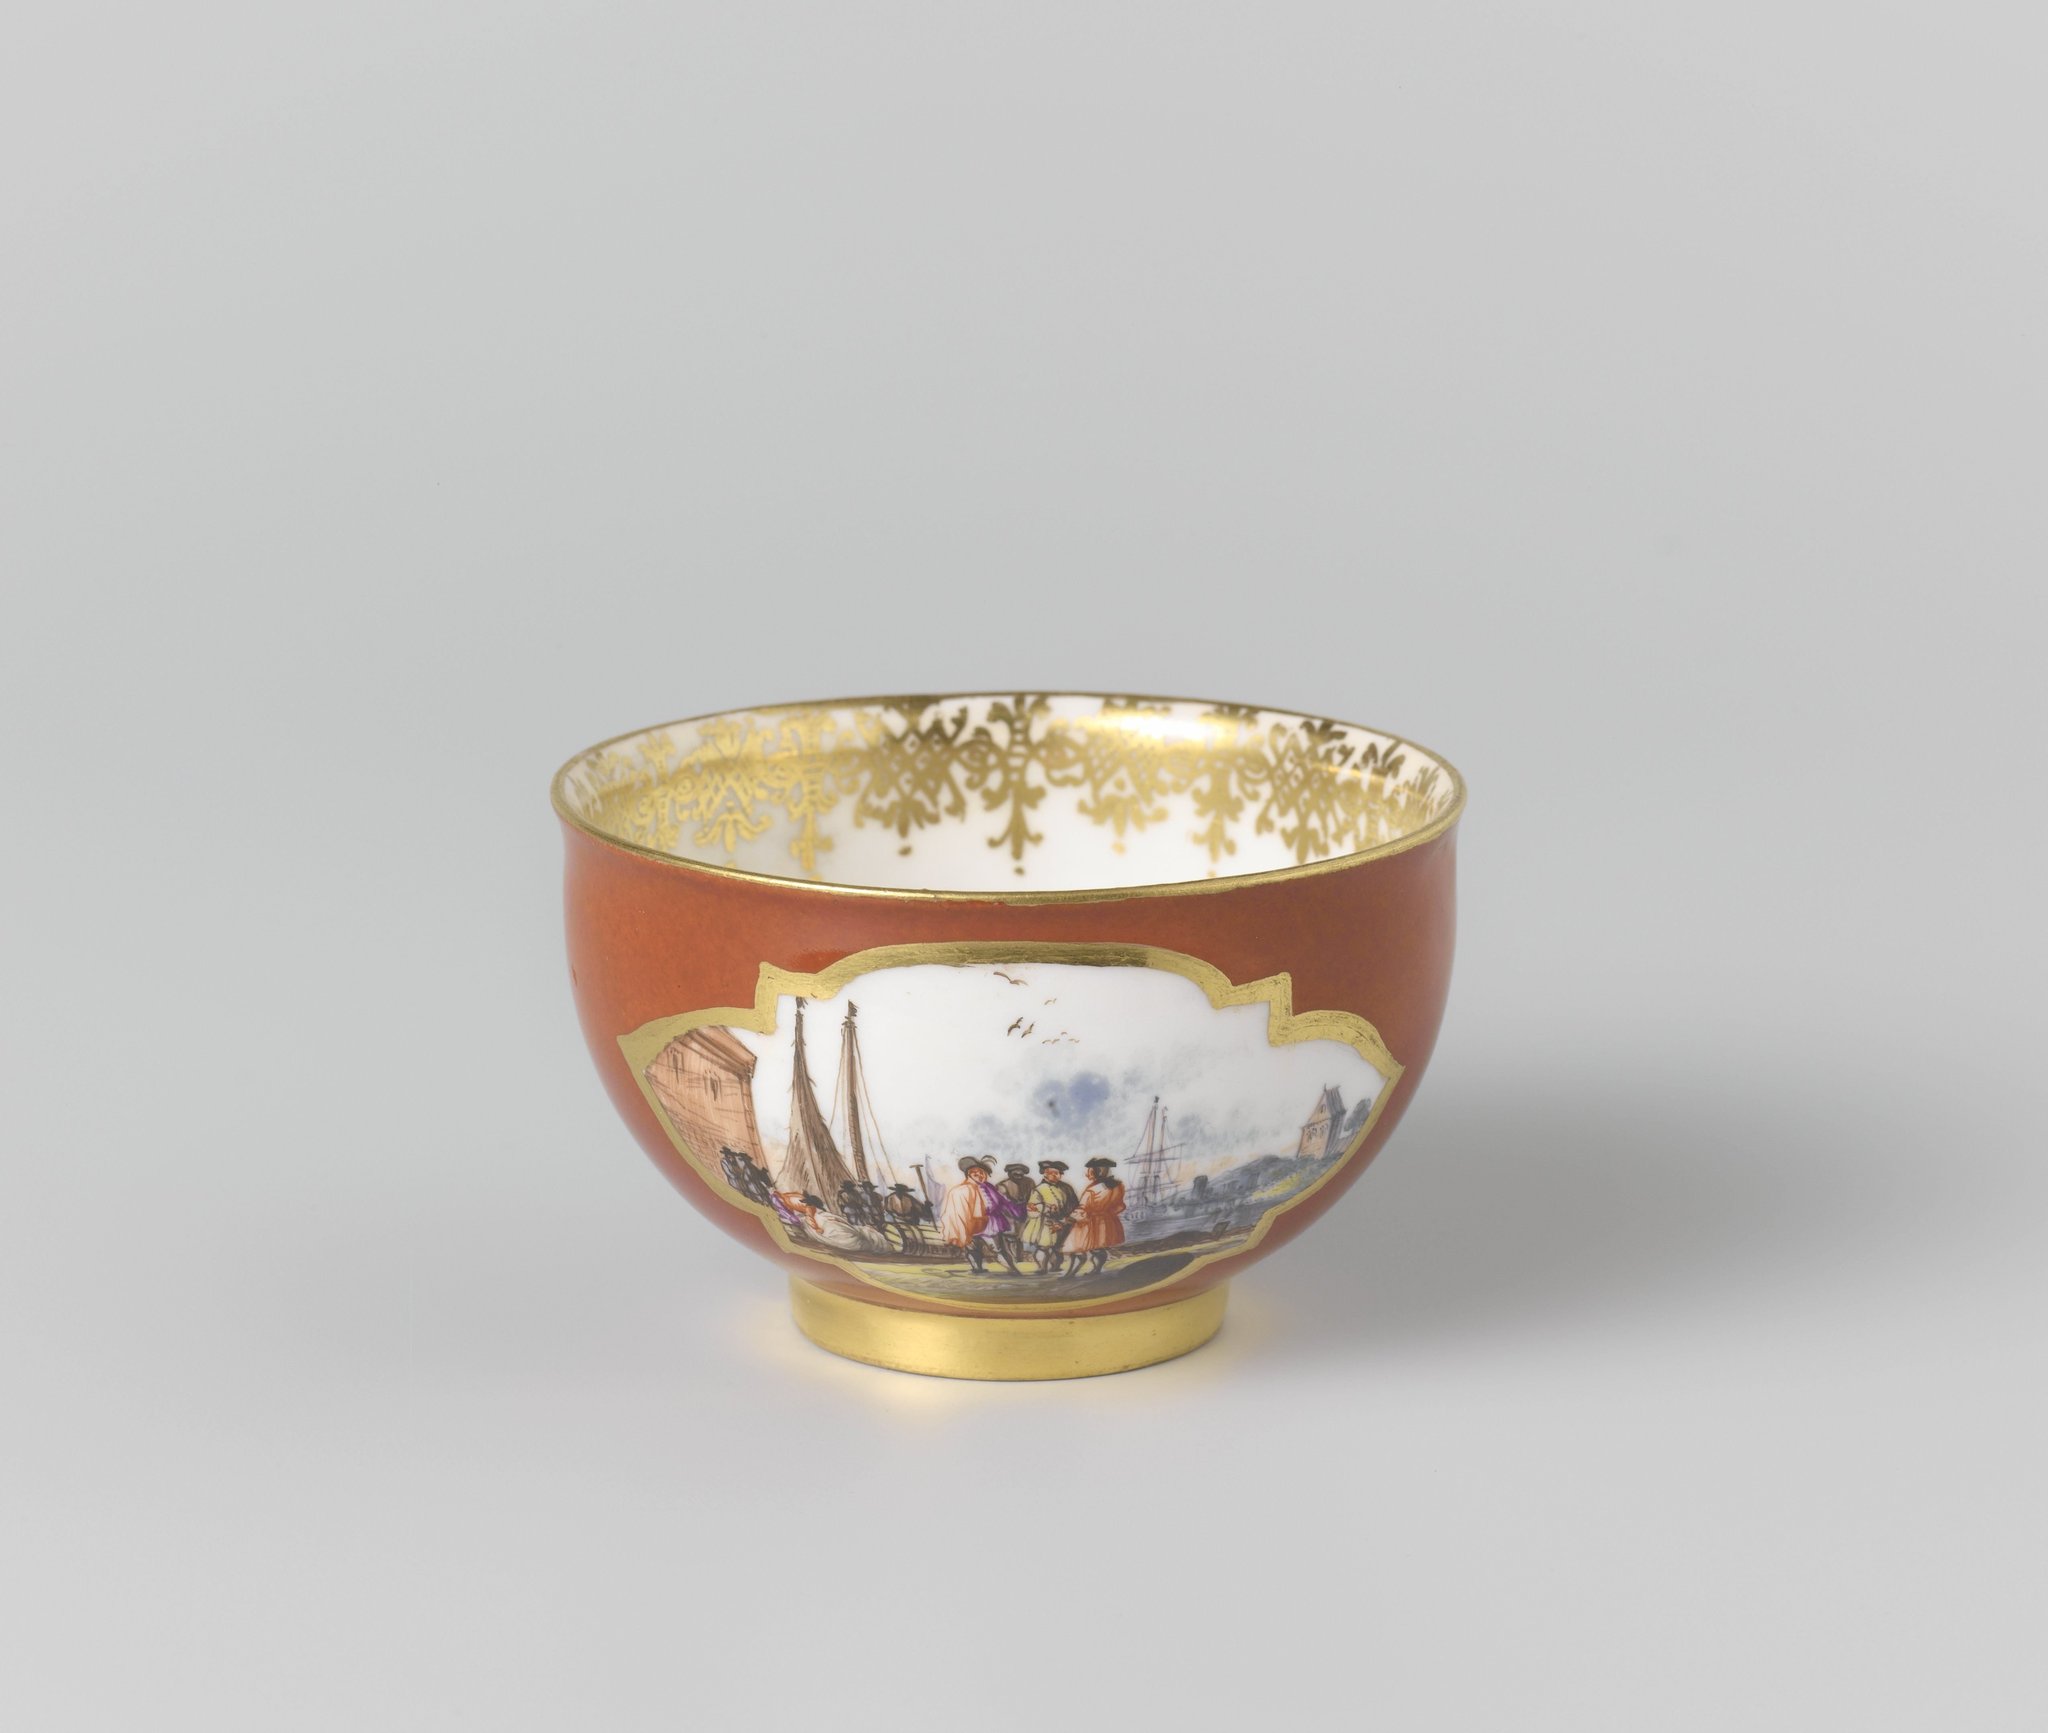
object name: cup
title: Kop, veelkleurig beschilderd met waterlandschappen in uitgespaarde vierpassen in een oranjerode fond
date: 1735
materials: porcelain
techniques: painted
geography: meissen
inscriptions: mark: ‘27’, factory mark, mold mark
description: Kop zonder oor, van beschilderd porselein. De kop is bedekt met een oranjerode fond, waarin accoladevormige vierpassen zijn uitgespaard met (water)landschappen met europese figuren, soms bij balen en schepen. De kop is gemerkt.